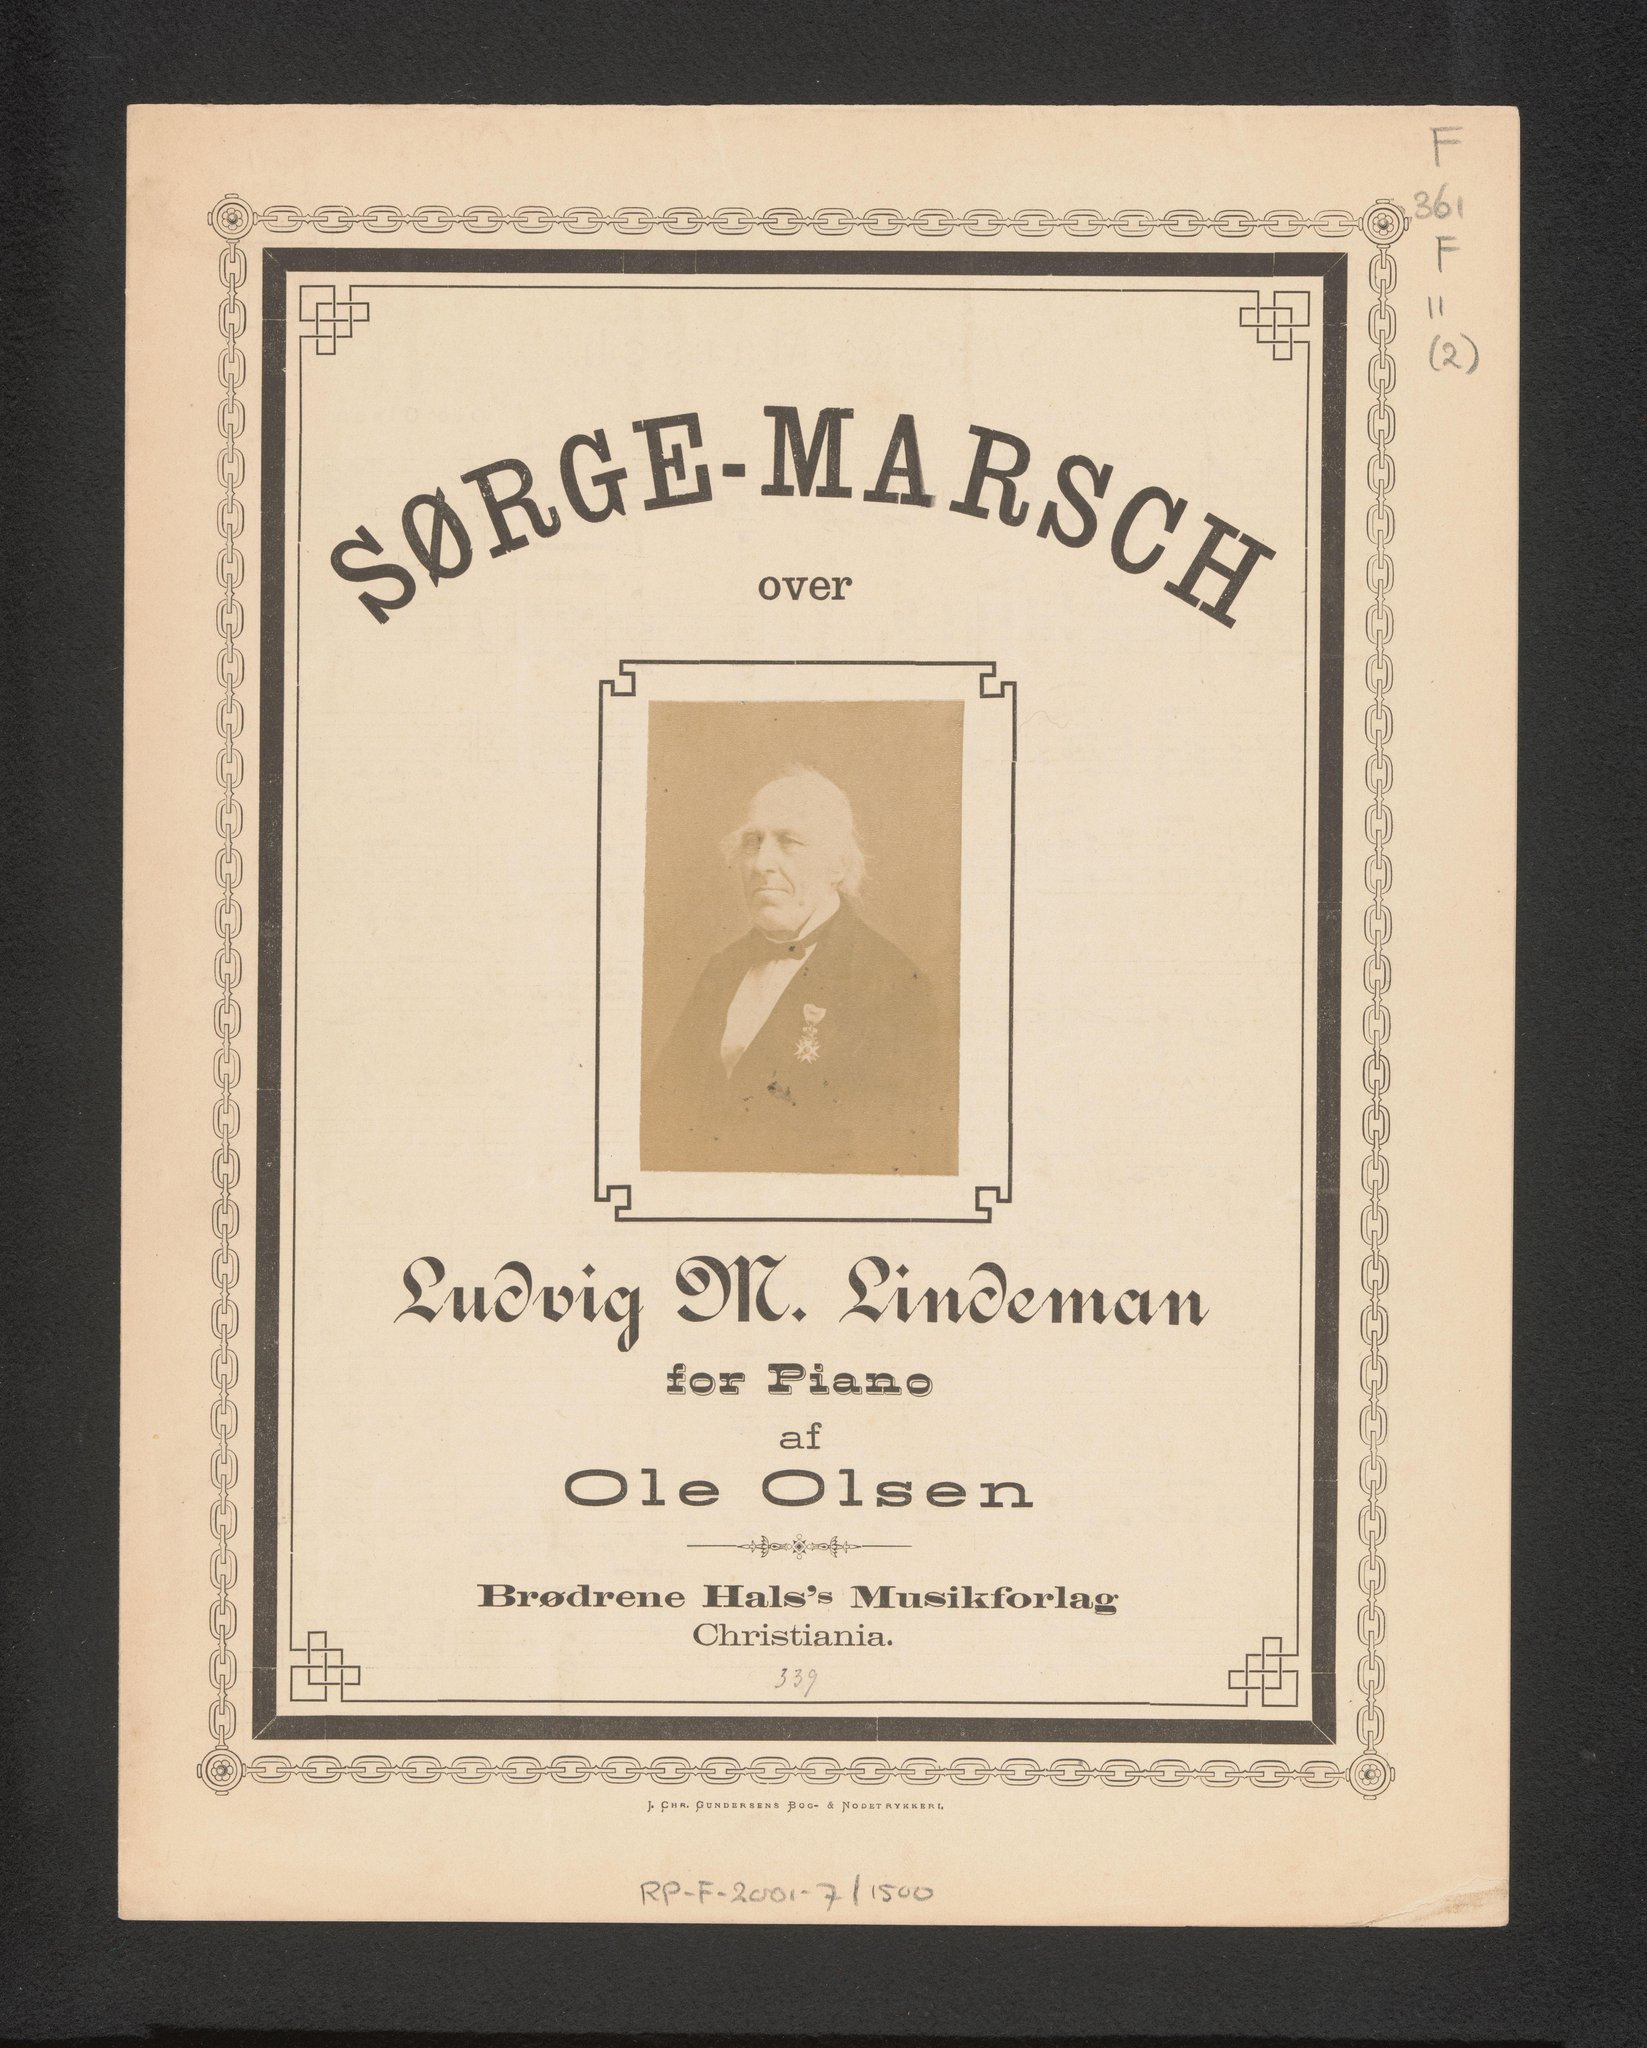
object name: book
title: Sorge-marsch over Ludvig M. Lindeman [Bladmuziek]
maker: ole olsen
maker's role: musician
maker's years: 1850-1927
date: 1865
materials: paper, photographic support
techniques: albumen print, printing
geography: christiania